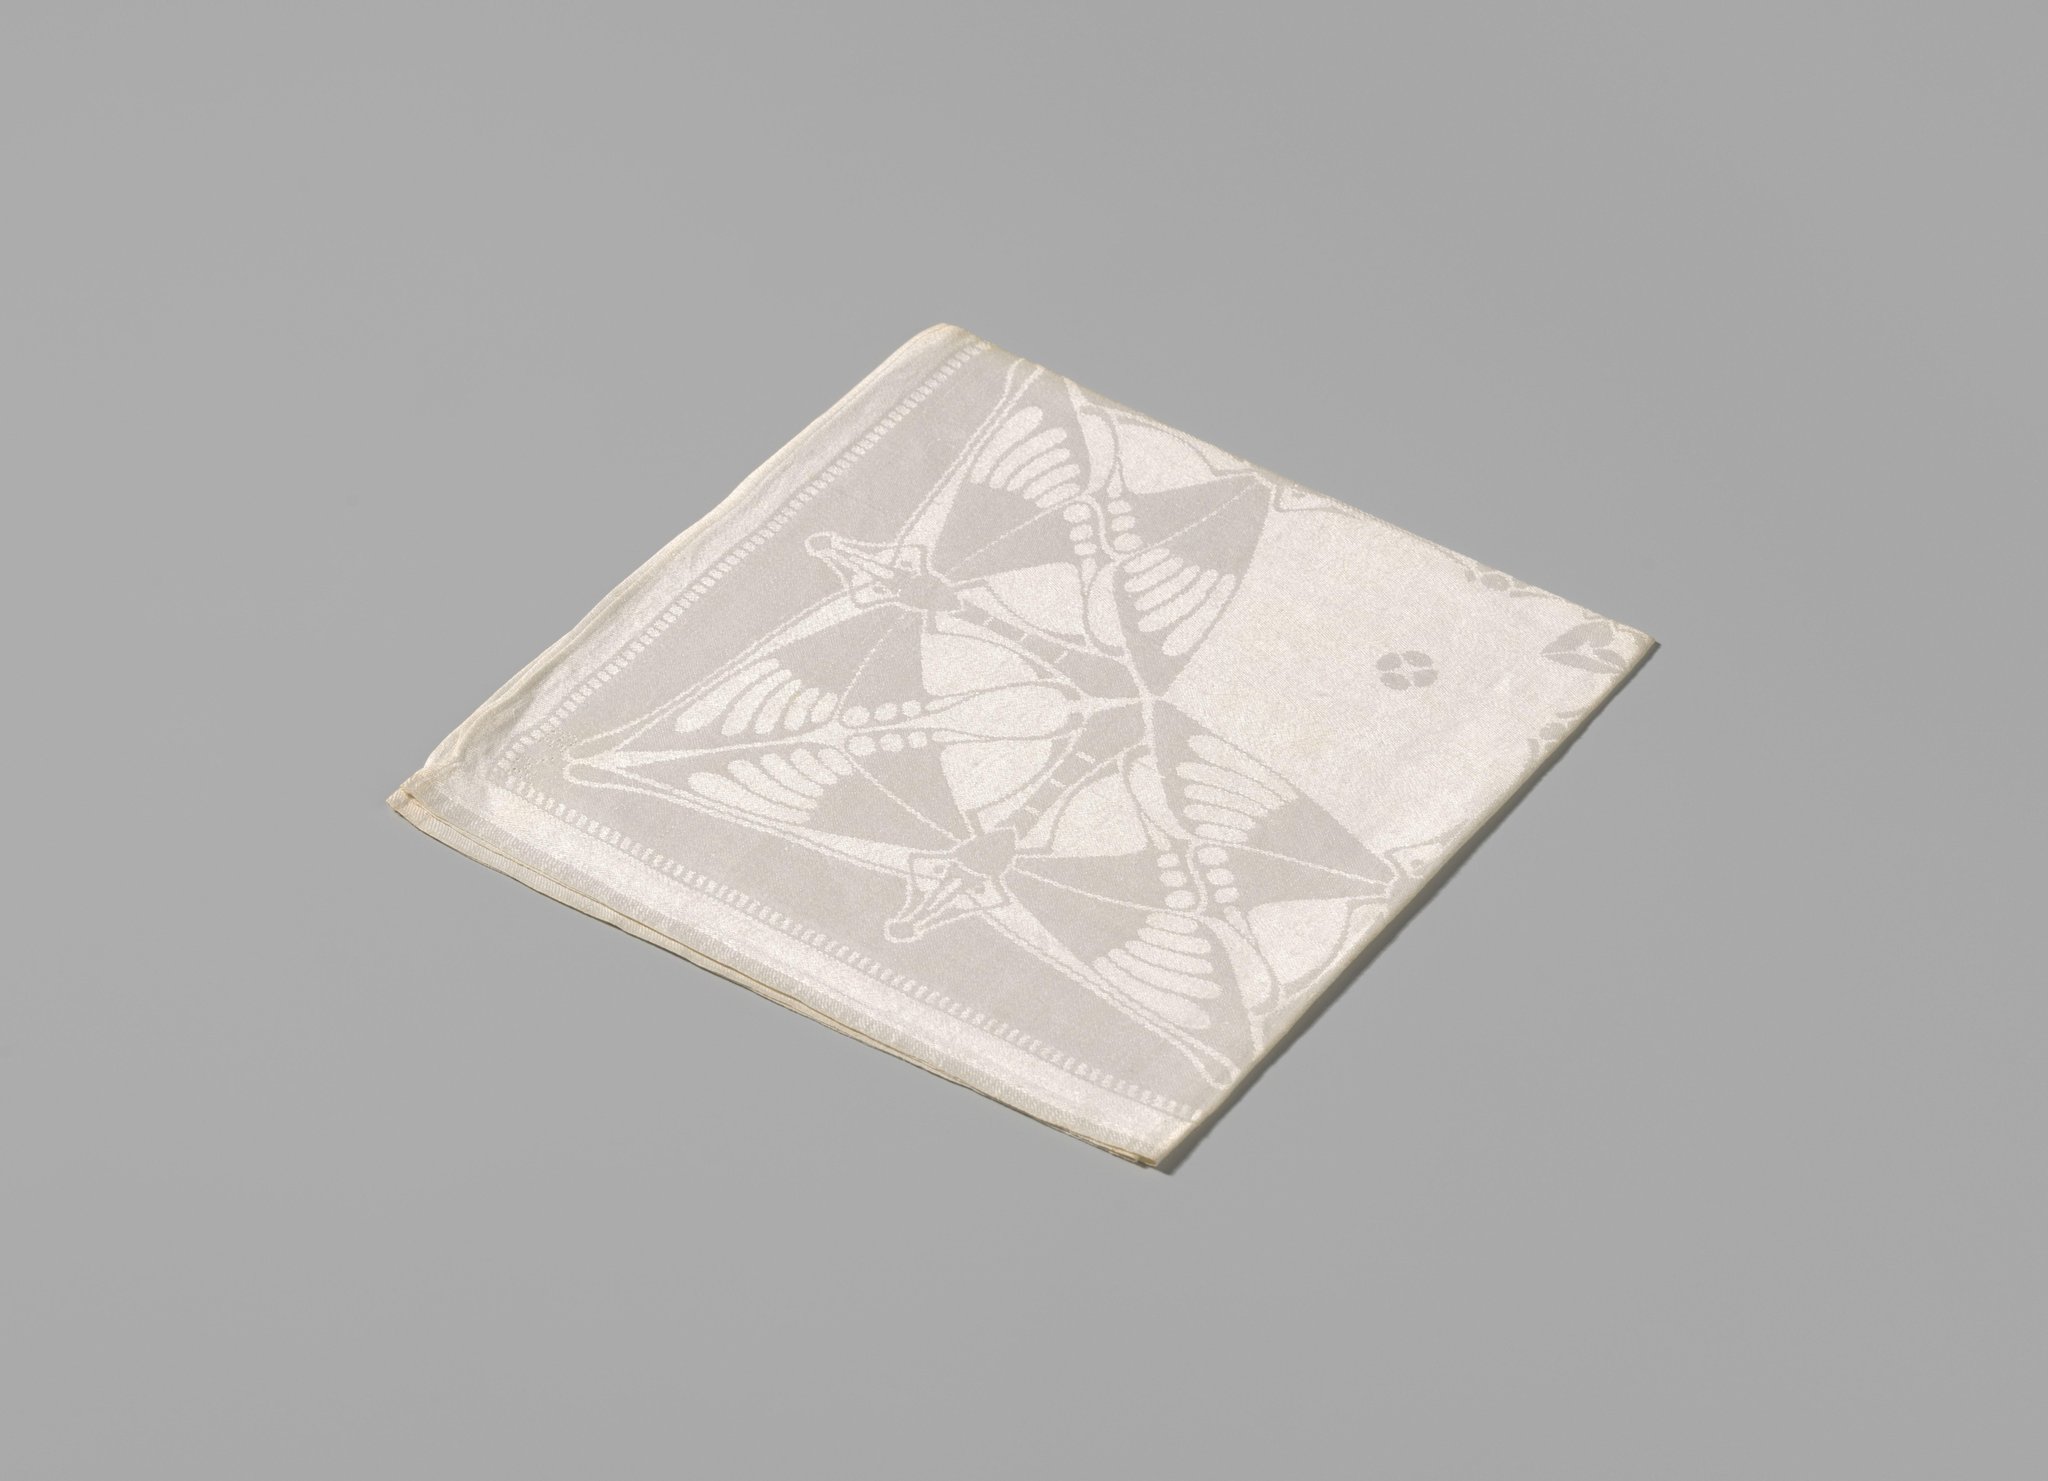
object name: vingerdoek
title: Vingerdoek van linnendamast met vlinders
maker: chris lebeau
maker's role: draughtsman, print maker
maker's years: 1878-1945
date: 1904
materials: linen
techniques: damask, weave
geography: eindhoven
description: Vingerdoek van linnendamast met vlinders: motief Vlinder, dessin nr. 505. De vingerdoek hoort bij elf vingerdoeken (BK-1979-260-A t/m BK-1979-260-L), dertien servetten (BK-1979-259-A t/m BK-1979-259-M) en twee tafellakens (BK-1979-258-A en BK-1979-258-B).